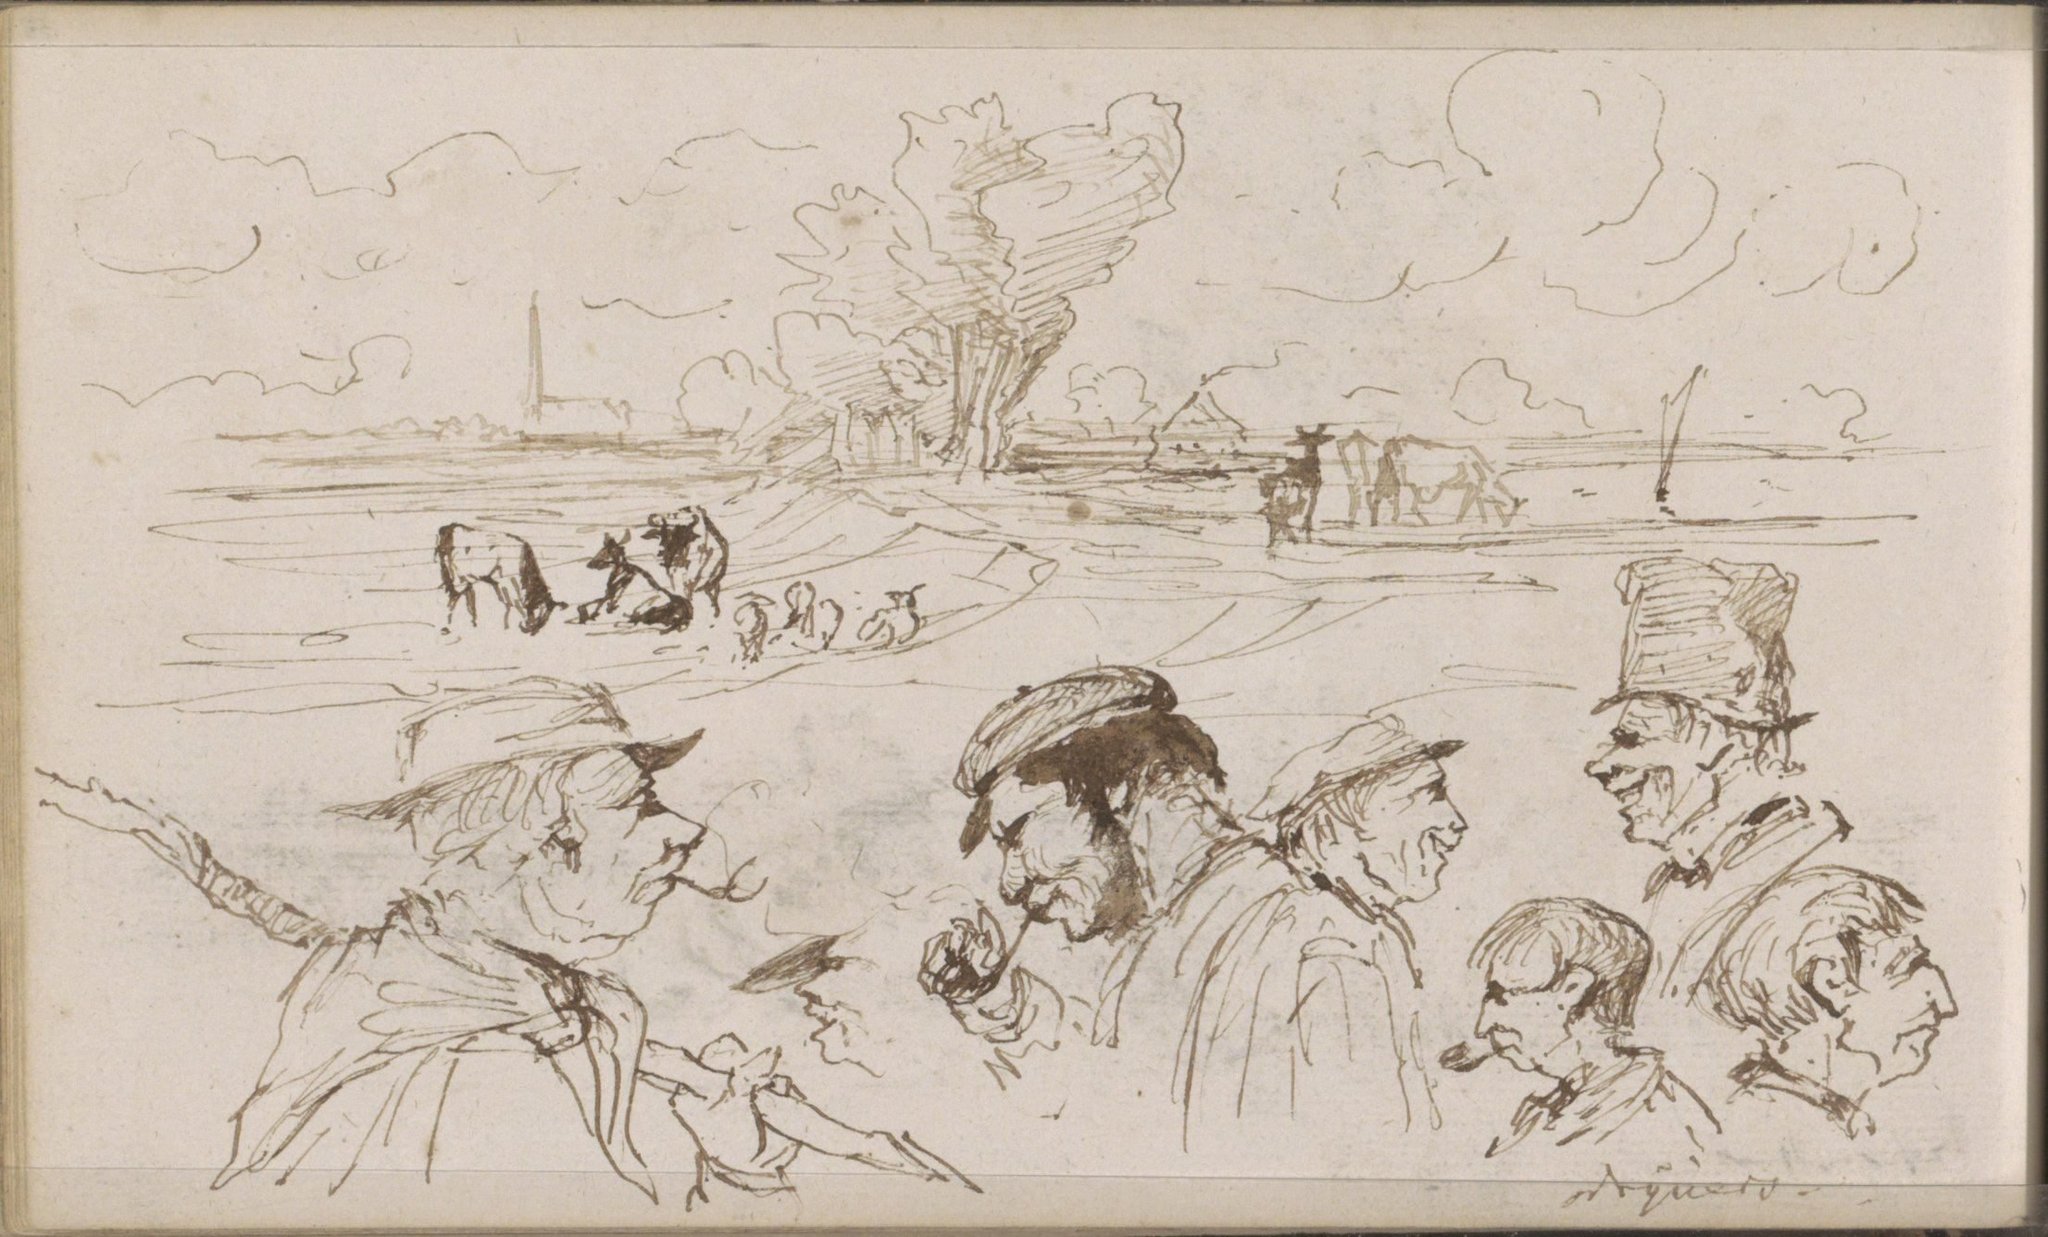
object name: sketchbook leaf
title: Weiland met grazende koeien en koppen van drijvers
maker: johannes tavenraat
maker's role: draughtsman, painter, print maker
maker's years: 1809-1881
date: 1864-1880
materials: ink, paper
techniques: pen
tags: head (human), cow, meadow, pasture, rowing-boat, canoe, etc.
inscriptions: annotation: ‘drijvers.’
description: Blad 54 verso uit een schetsboek met 98 bladen.